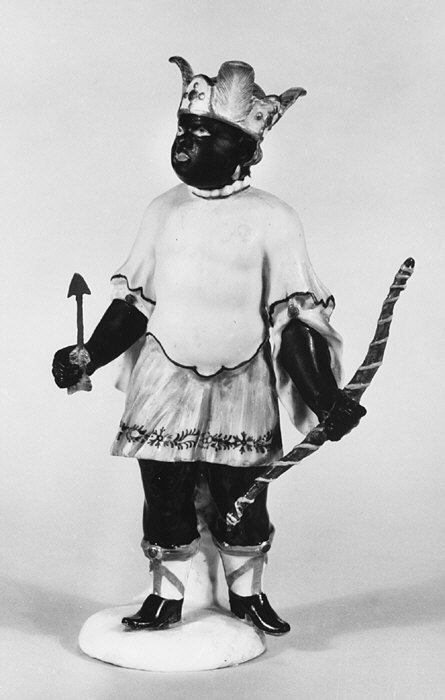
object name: figure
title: Africa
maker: royal porcelain manufactory, berlin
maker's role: manufactory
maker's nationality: german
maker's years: 1763-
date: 1751-1757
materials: hard paste porcelain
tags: bow and arrow,men